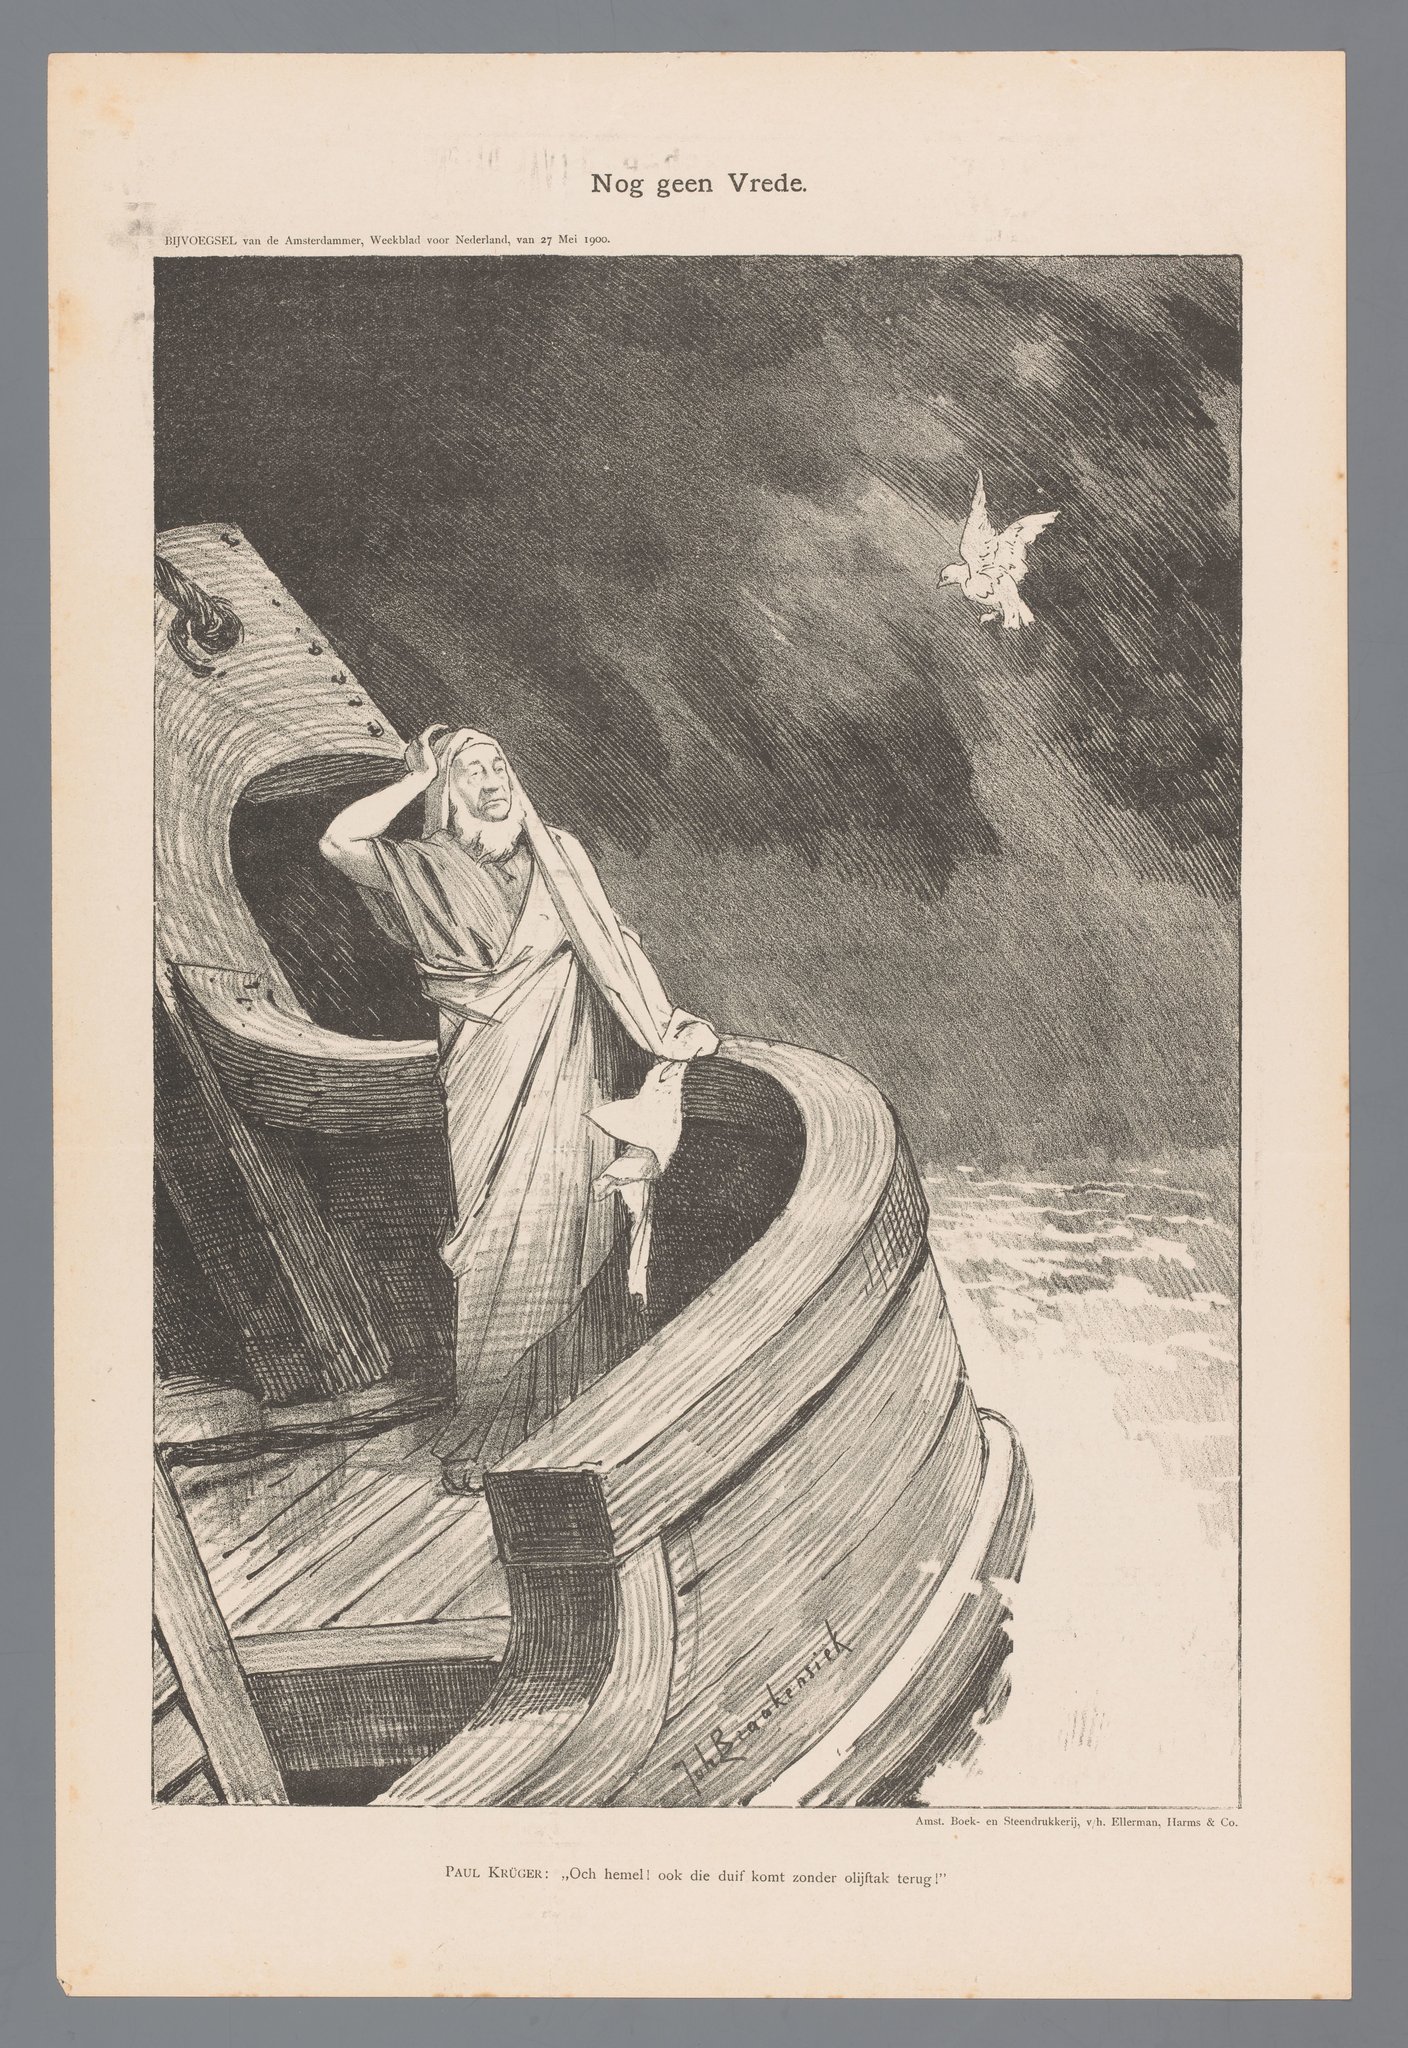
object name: cartoon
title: Nog geen Vrede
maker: johan braakensiek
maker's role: draughtsman, print maker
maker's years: 1858-1940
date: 1900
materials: paper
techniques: lithograph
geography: amsterdam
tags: the dove returns with an olive-branch ~ story of noah, historical persons, political caricatures and satires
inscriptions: date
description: Prent uit het bijvoegsel van: De Amsterdammer. Weekblad voor Nederland, 27 mei 1900.